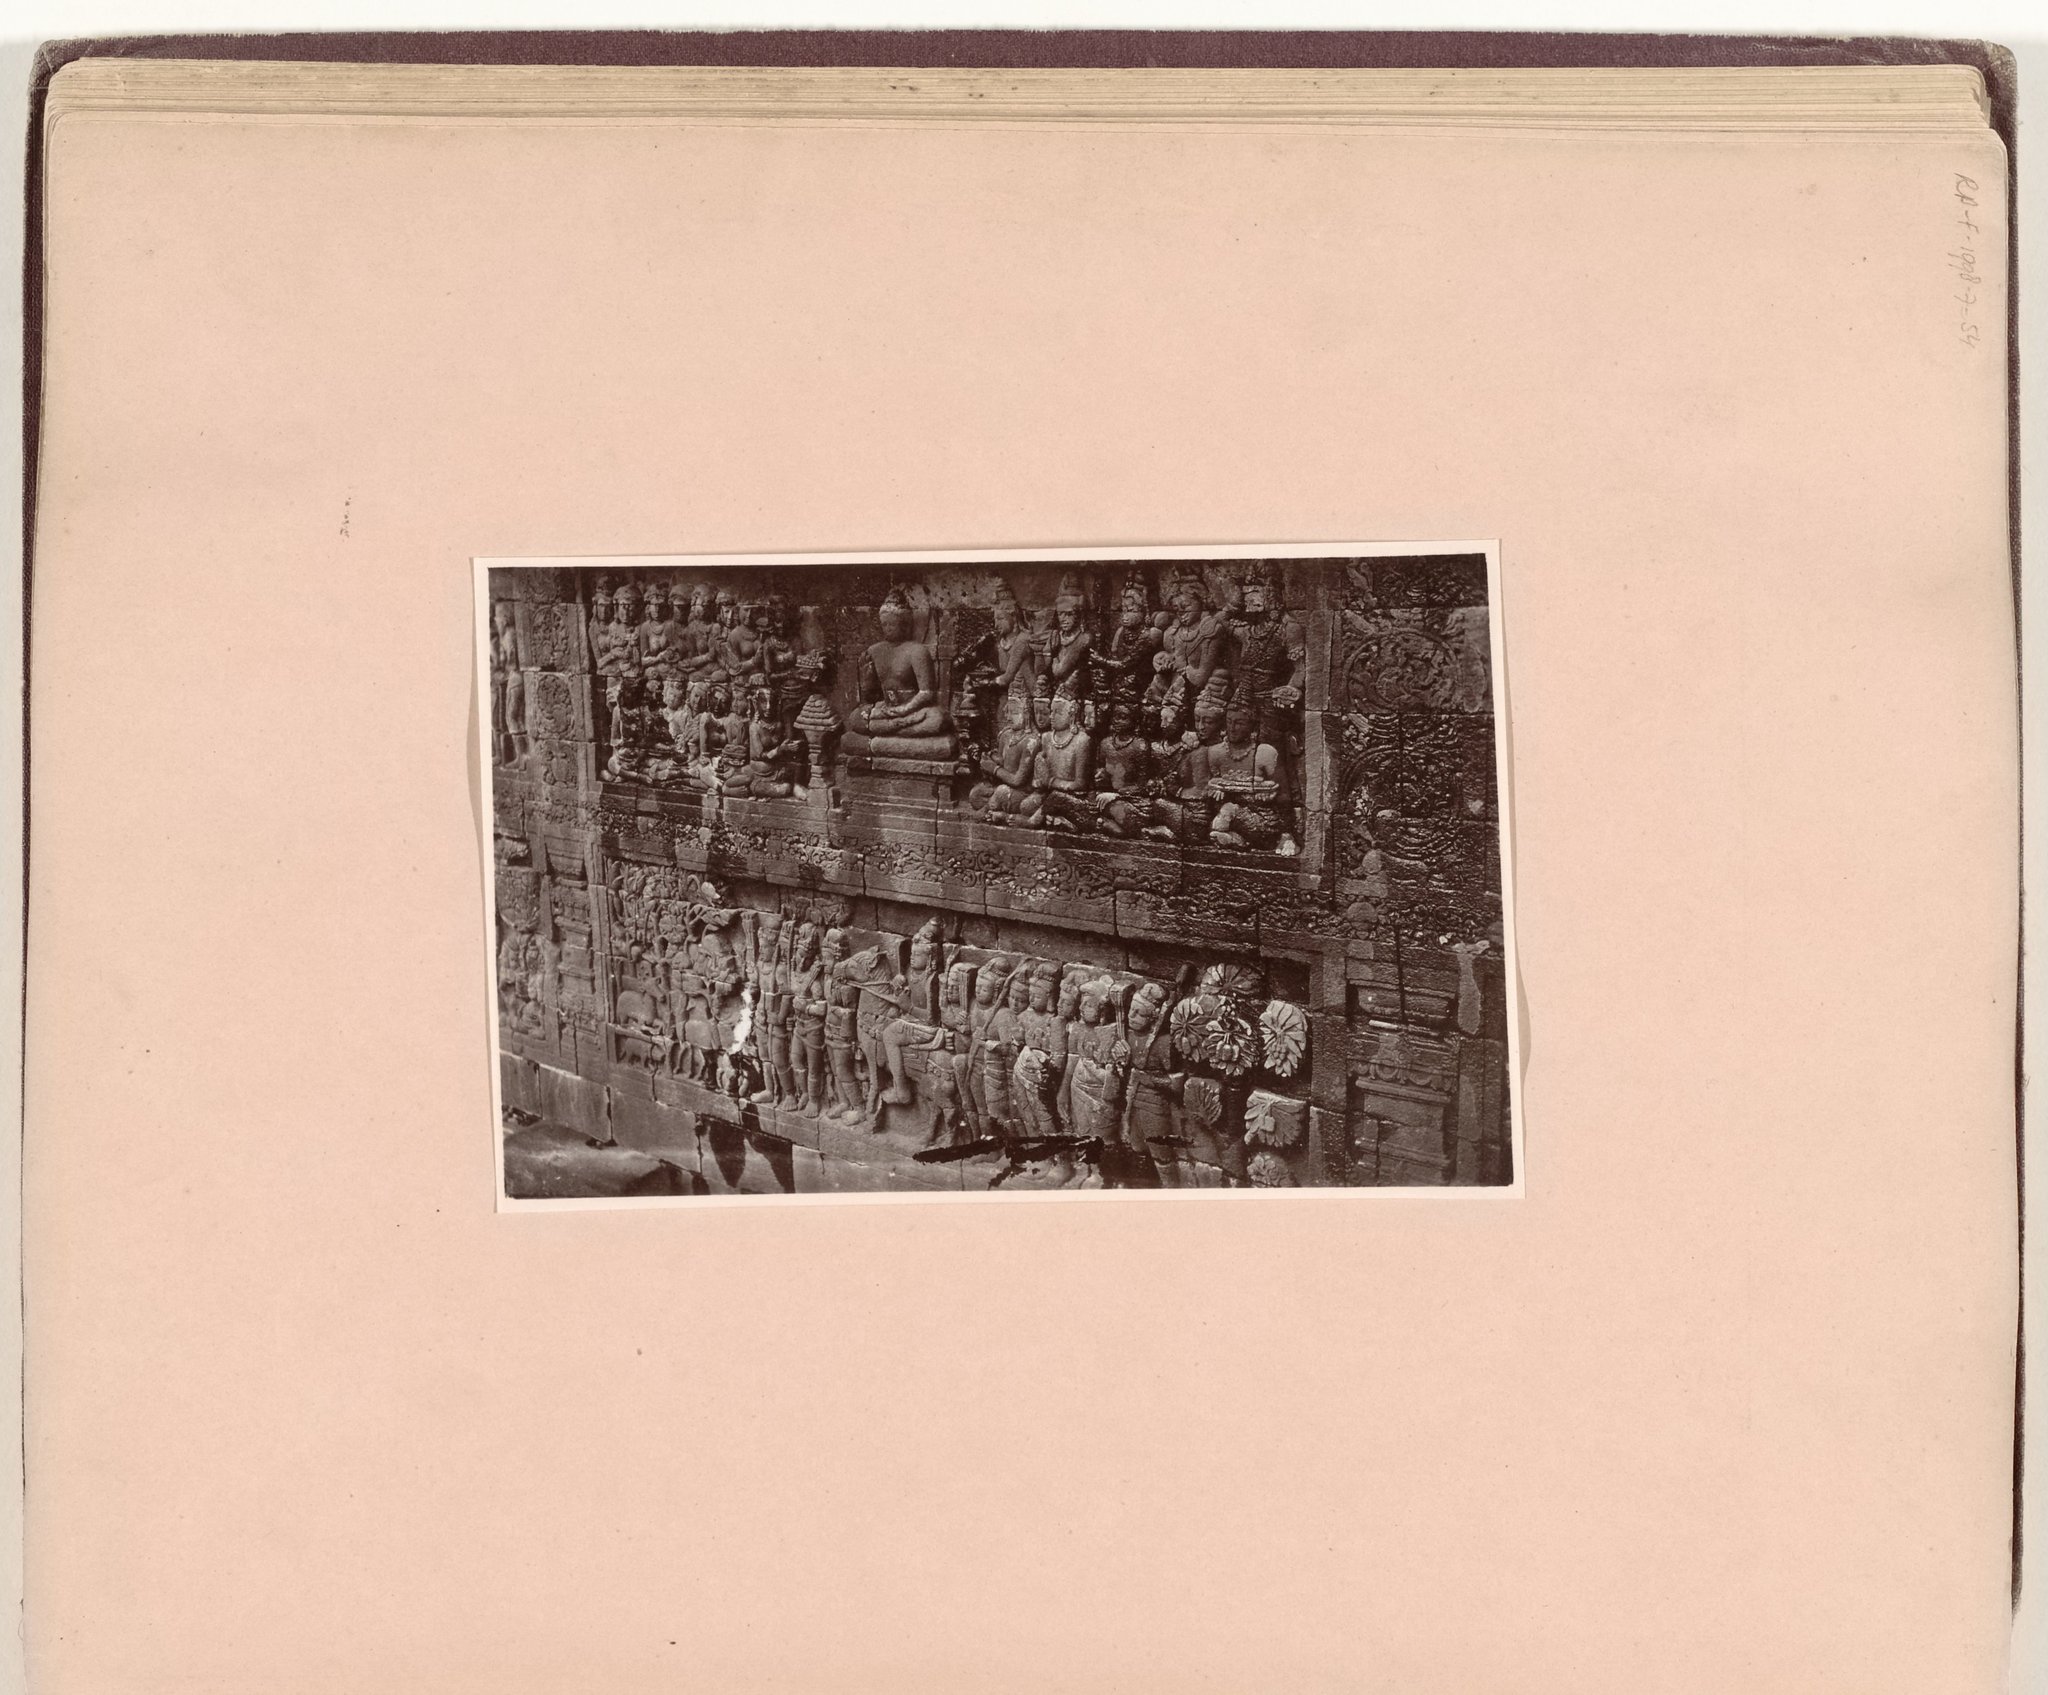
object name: photograph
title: Reliëfs van de Borobudur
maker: c. dietrich (fotograaf)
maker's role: fotograaf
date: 1875-1890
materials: cardboard, paper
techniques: albumen print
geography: java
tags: sculpture (+ relief ~ sculpture)